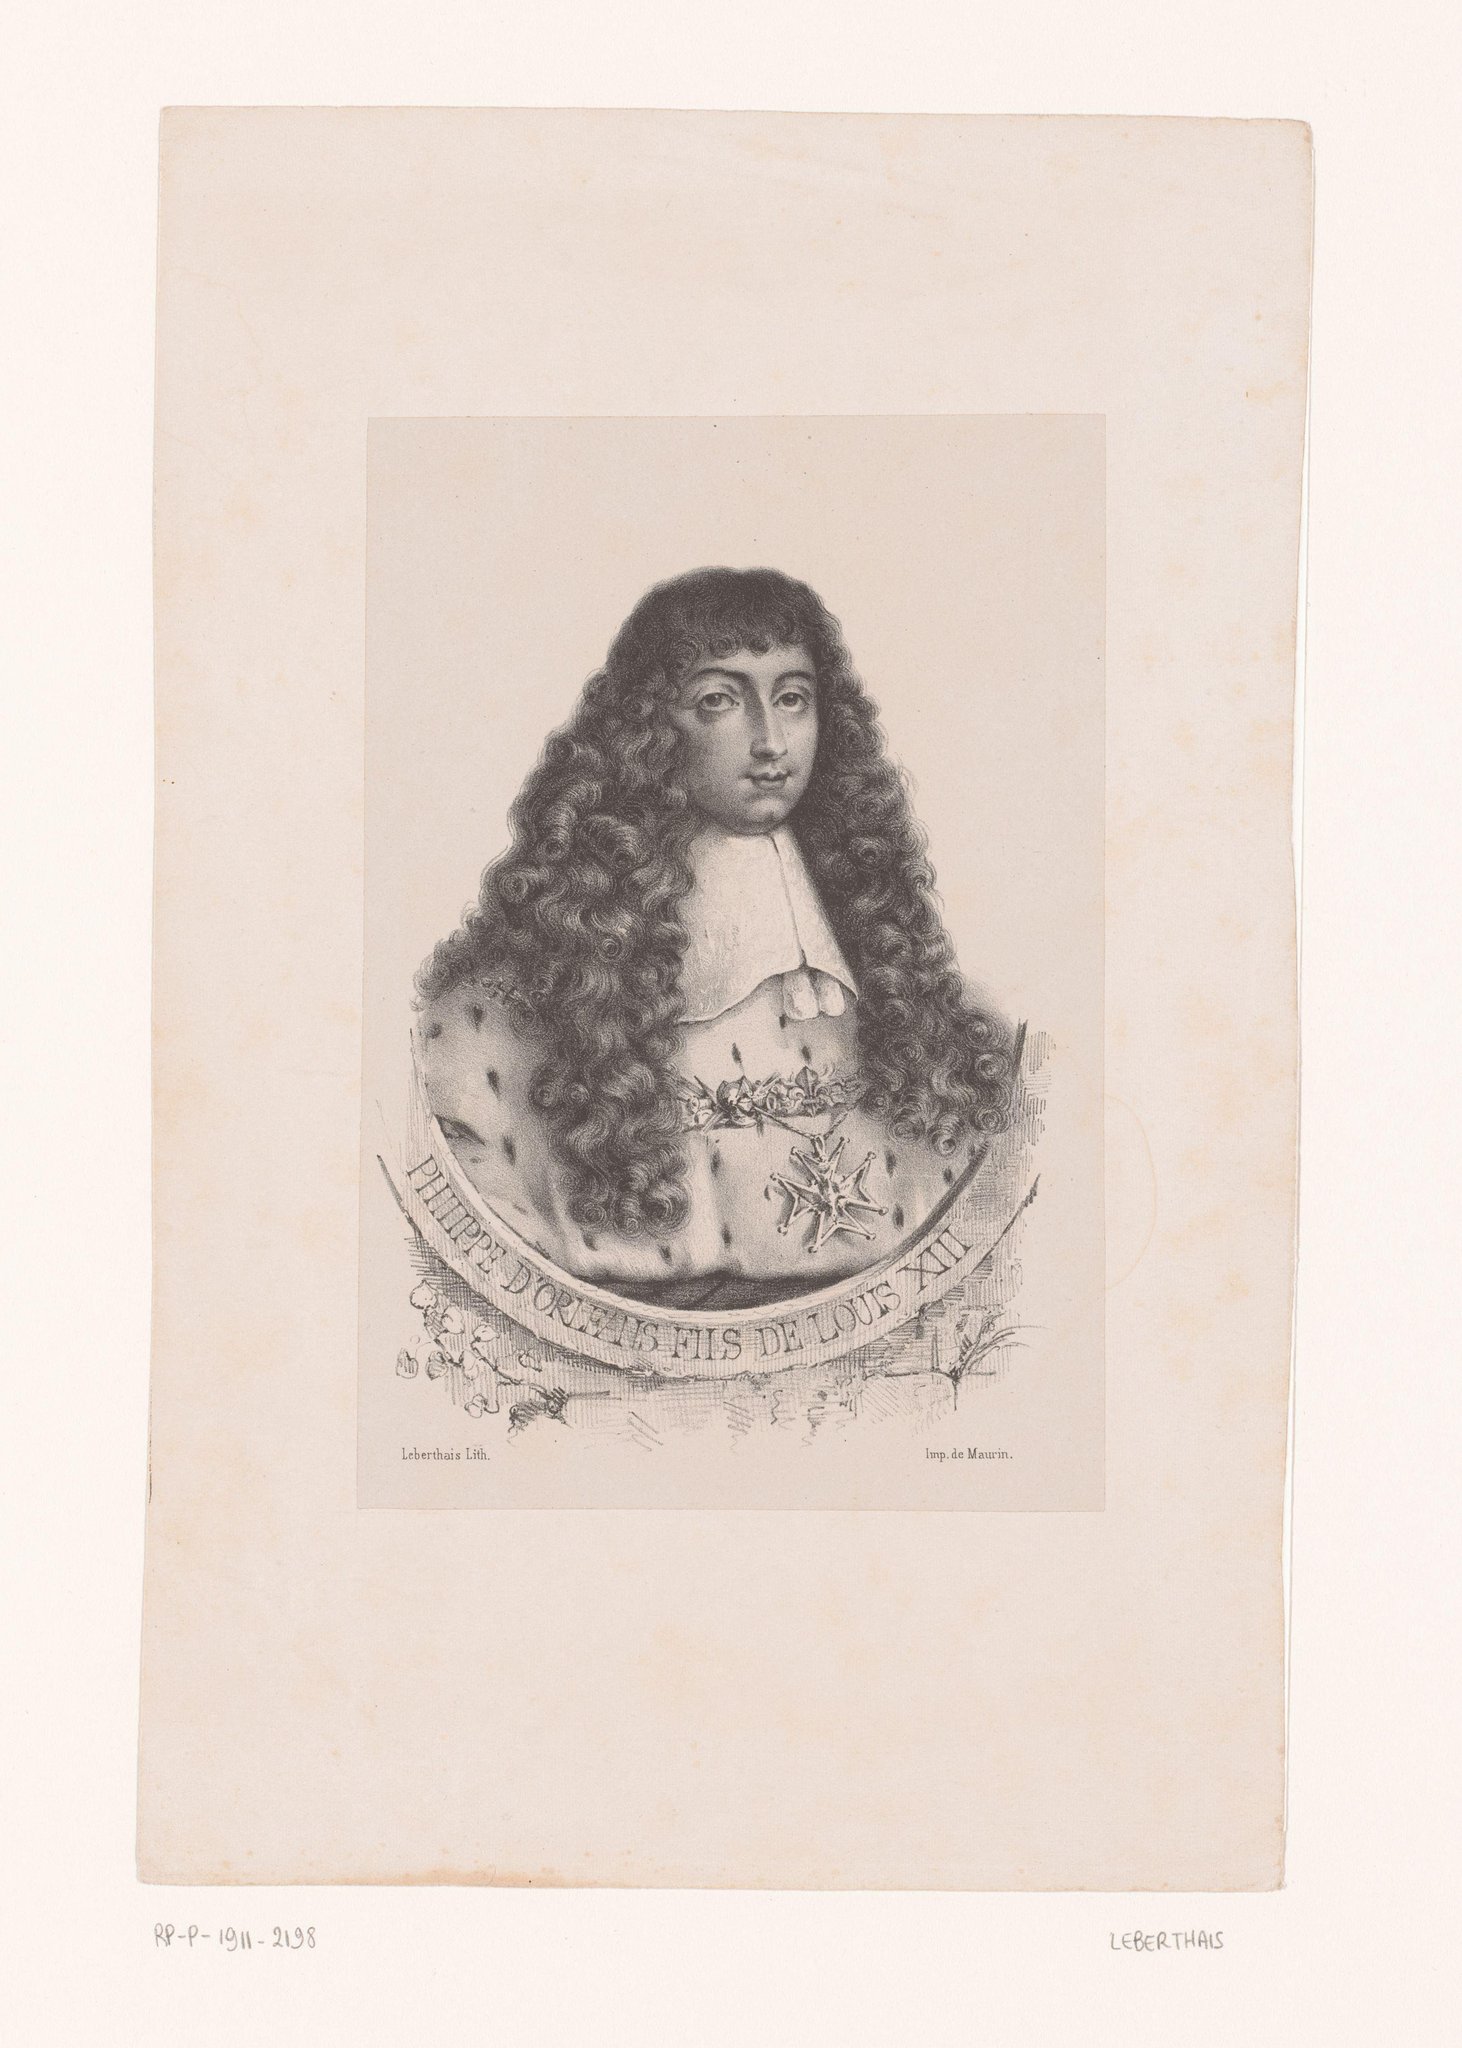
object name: print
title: Portret van Filips van Frankrijk, hertog van Orléans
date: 1836-1865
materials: paper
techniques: lithograph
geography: paris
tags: filips i (hertog van orléans), historical persons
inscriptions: collector's mark: Lugt 2228a